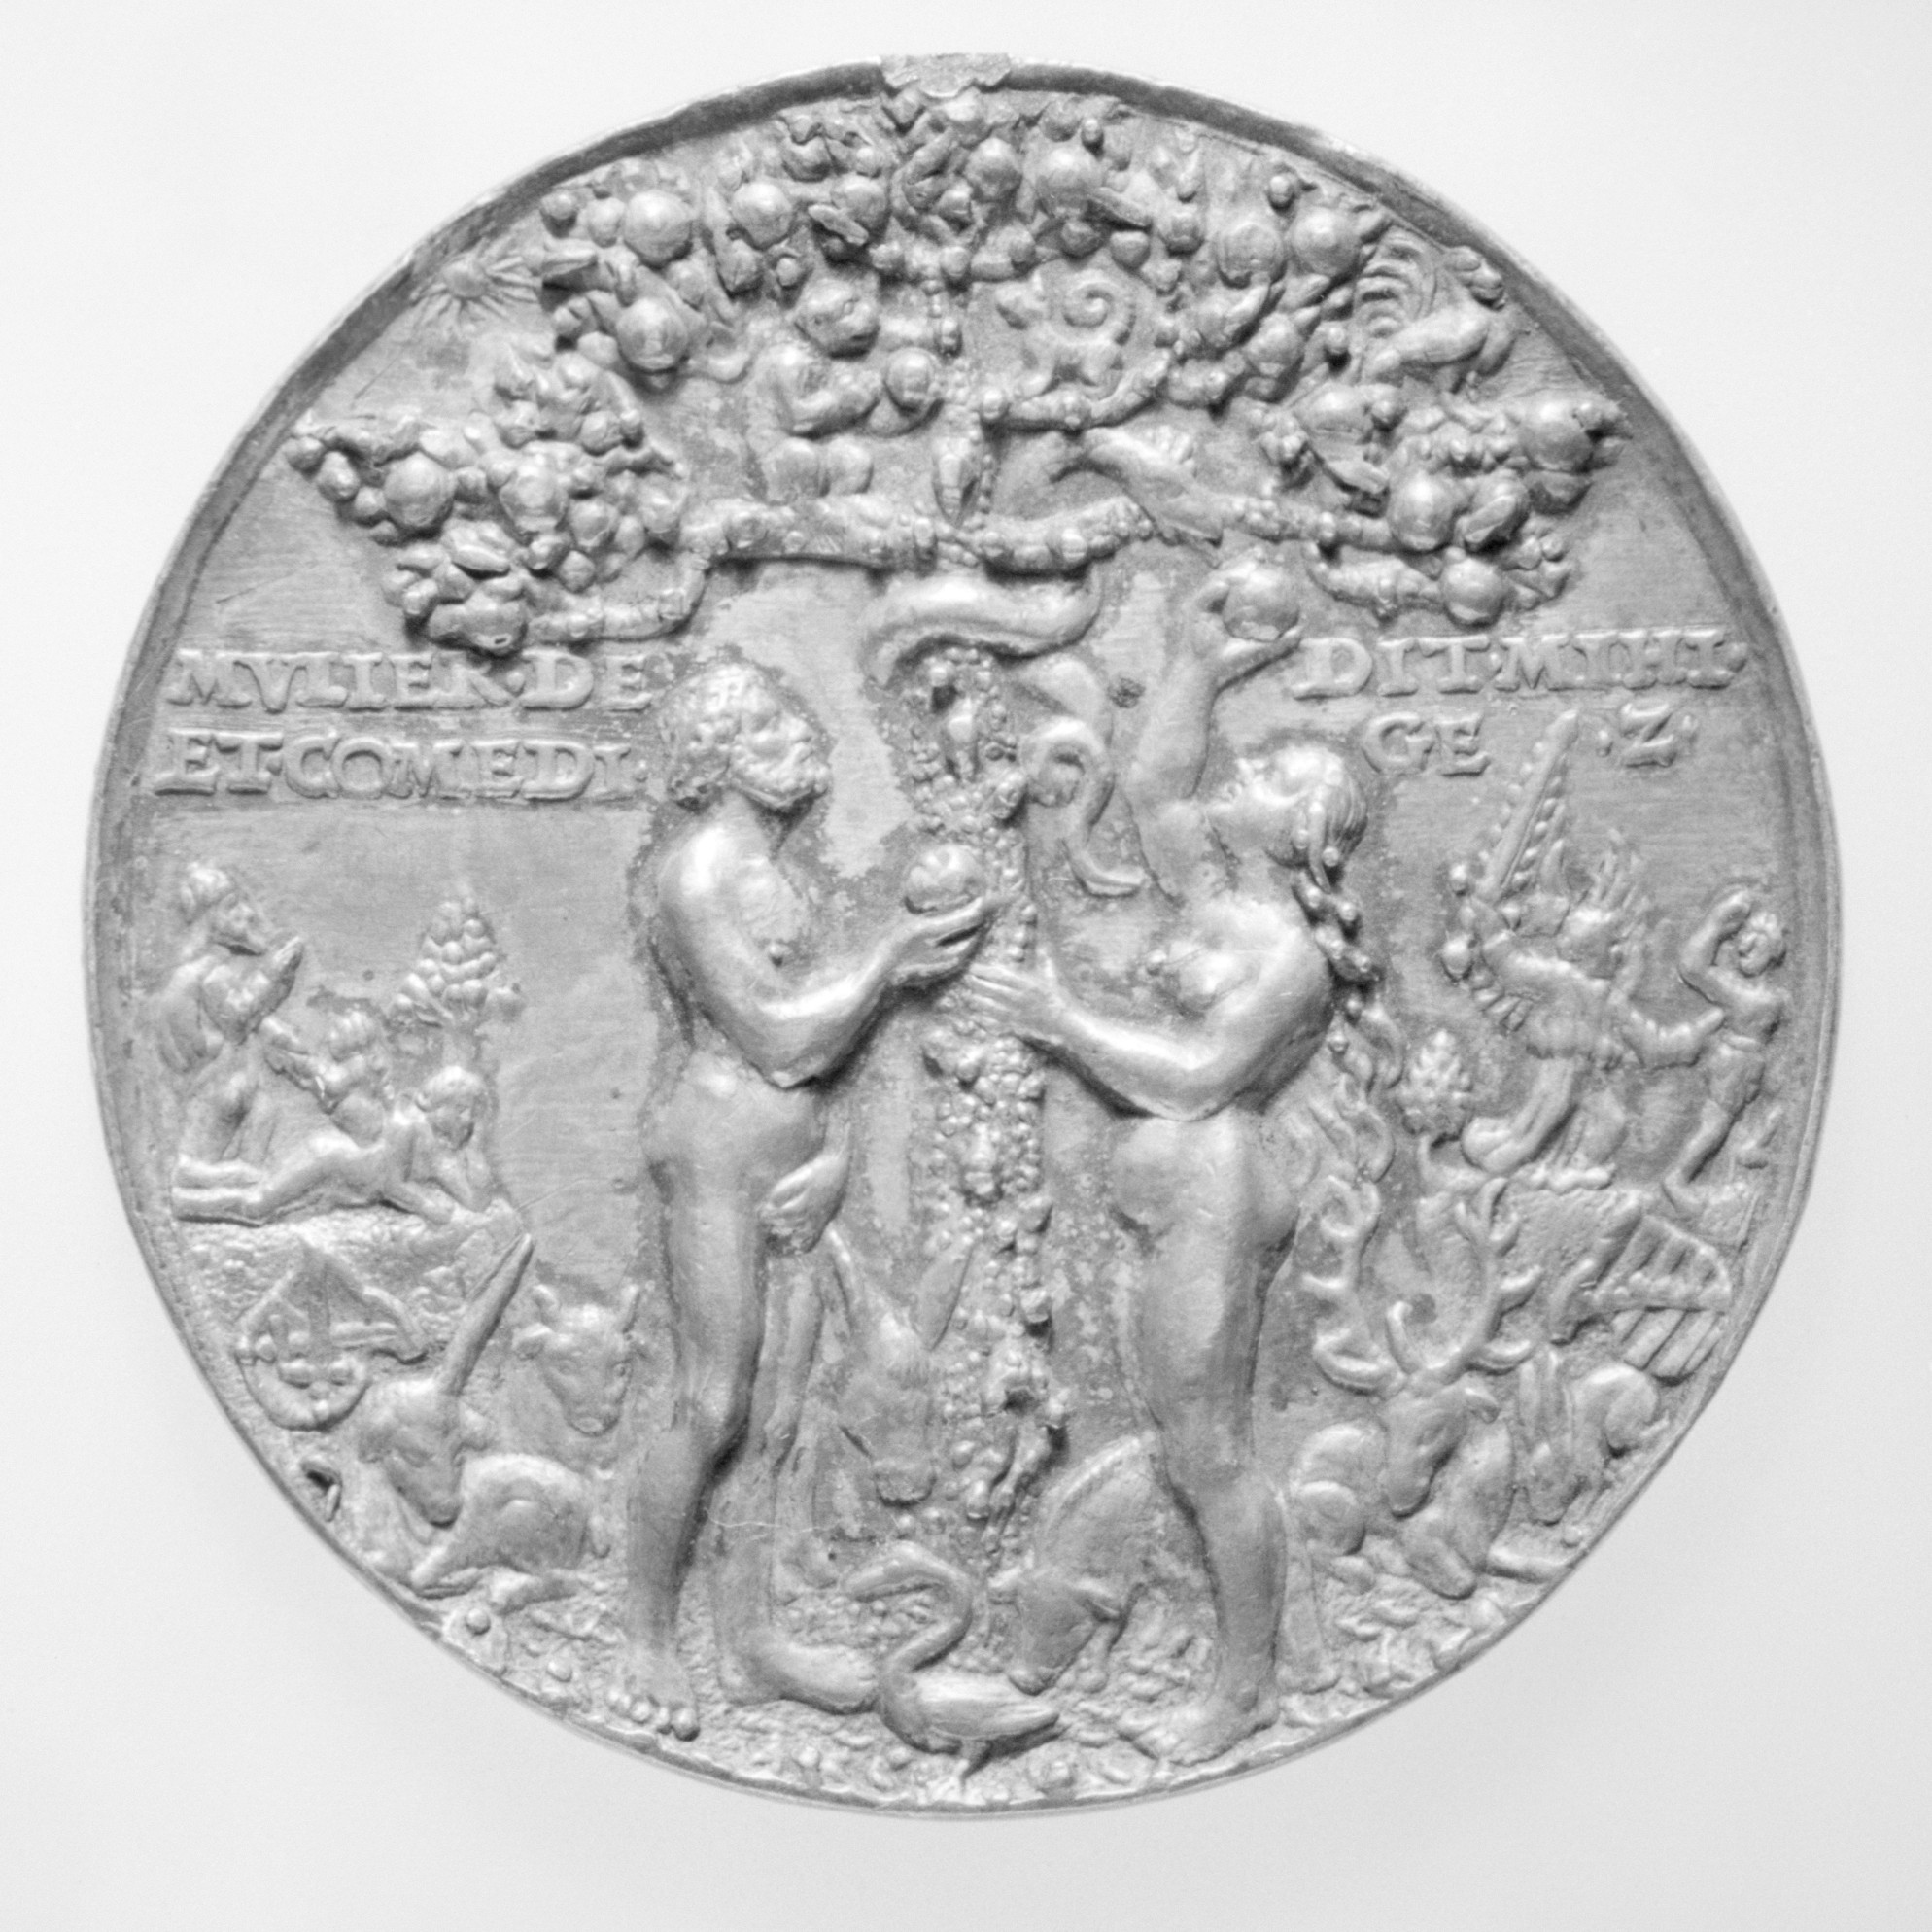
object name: medal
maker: hans reinhart the elder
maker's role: artist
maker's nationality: german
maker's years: 1500-1581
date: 1501-1600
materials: silver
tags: fruit,male nudes,female nudes,trees